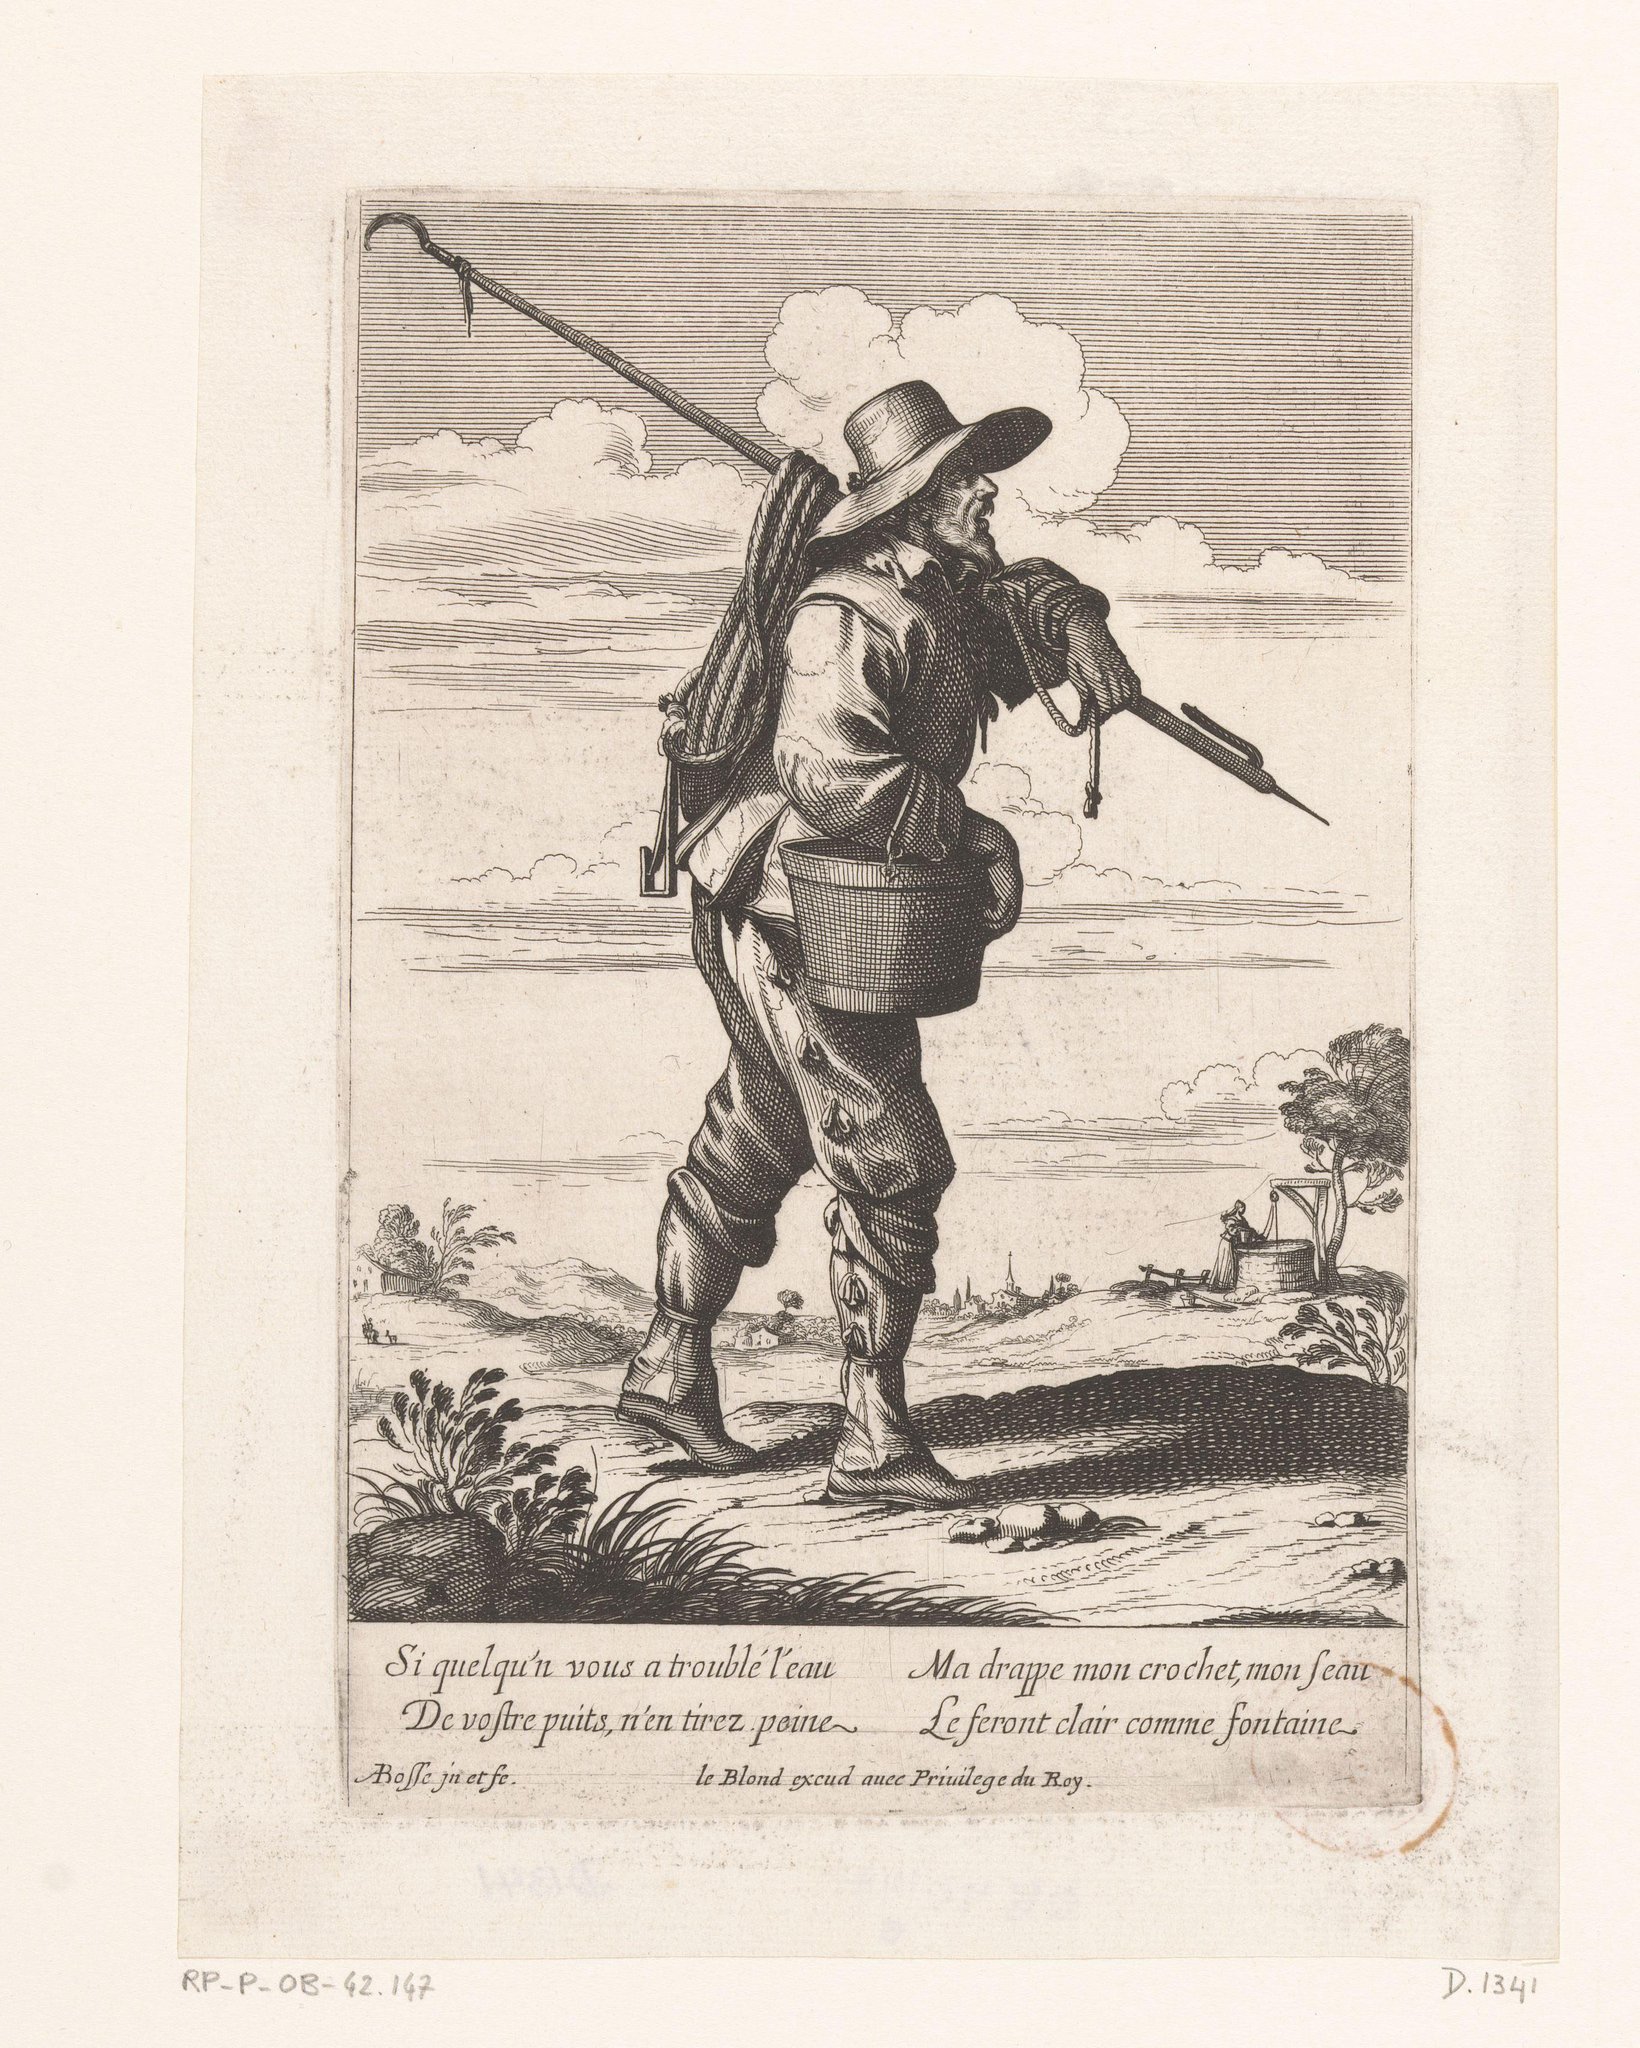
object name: print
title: Straatverkopers en dienstverleners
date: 1629-1630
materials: paper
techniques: engraving, etching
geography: paris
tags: tools, aids, implements ~ crafts and industries, well, handicrafts ~ maintenance and repair, wandering or travelling merchant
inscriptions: collector's mark: Lugt 240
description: Maakt deel uit van een serie van twaalf prenten met straatverkopers en dienstverleners, uitgegeven door Jean Leblond (I) tussen 1629-1630 te Parijs.